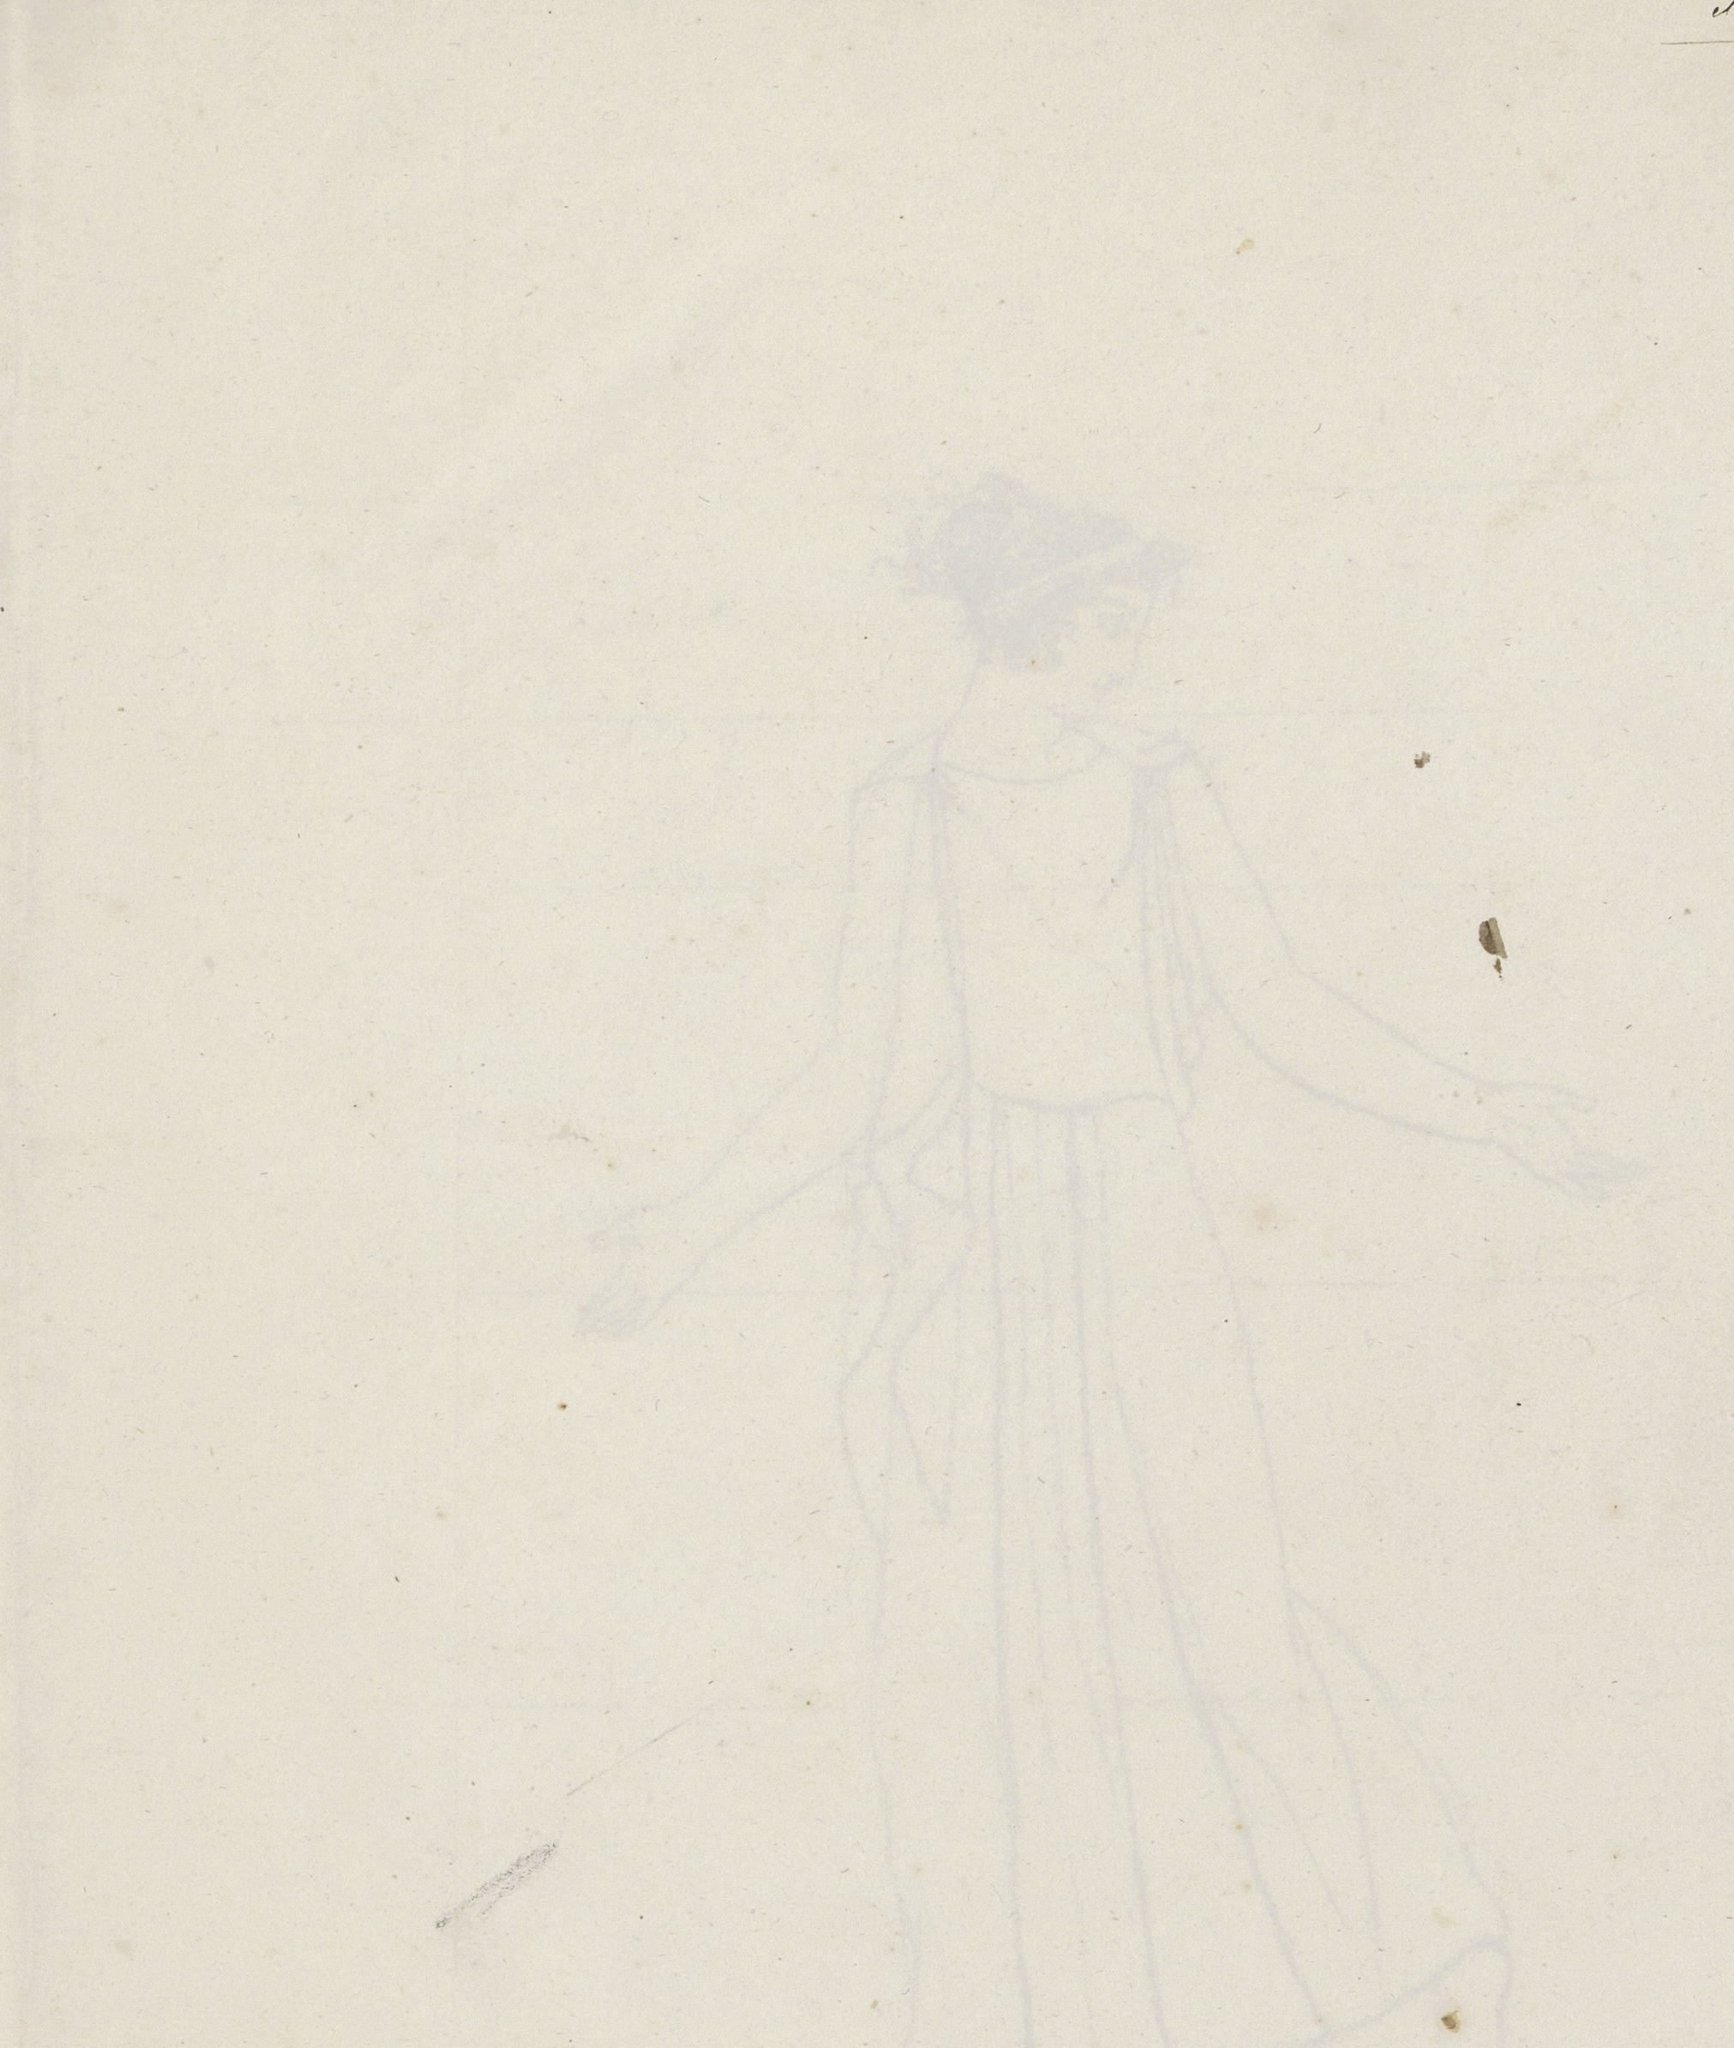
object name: sketchbook leaf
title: Datum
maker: jonkvrouw elisabeth kemper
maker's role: draughtsman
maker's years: 1799-1871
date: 1816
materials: ink, paper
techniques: pen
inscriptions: date: ‘1816’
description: Blad 1 recto uit een schetsboek met 94 bladen.